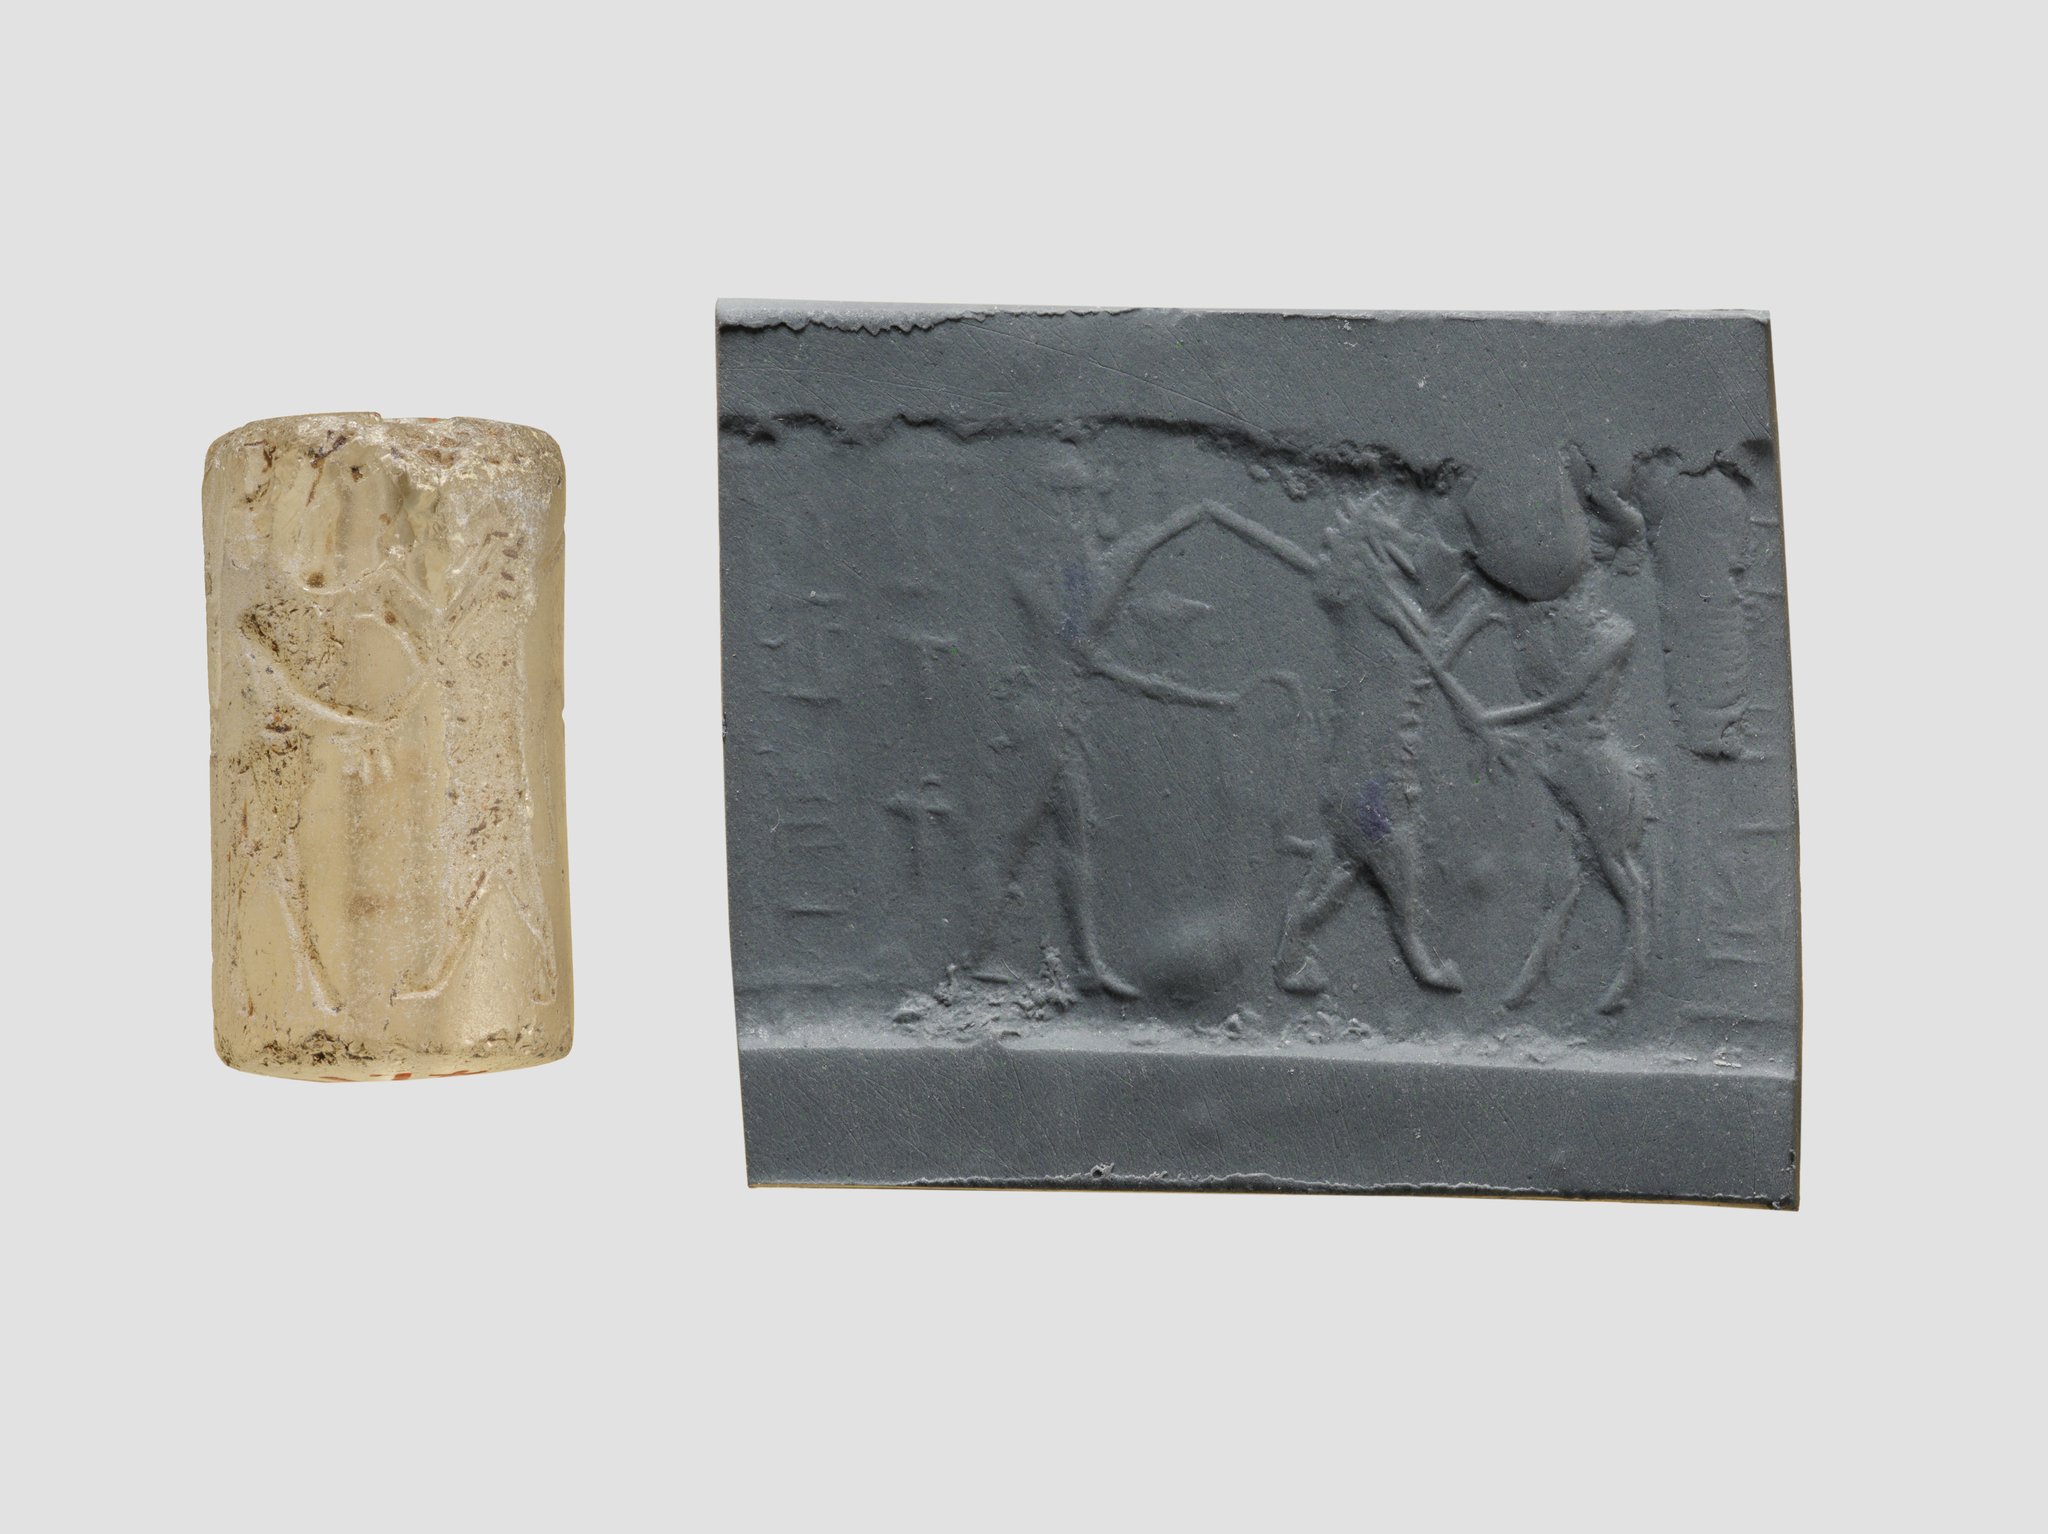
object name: cylinder seal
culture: neo-sumerian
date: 2112-2004 BCE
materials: quartz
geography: mesopotamia